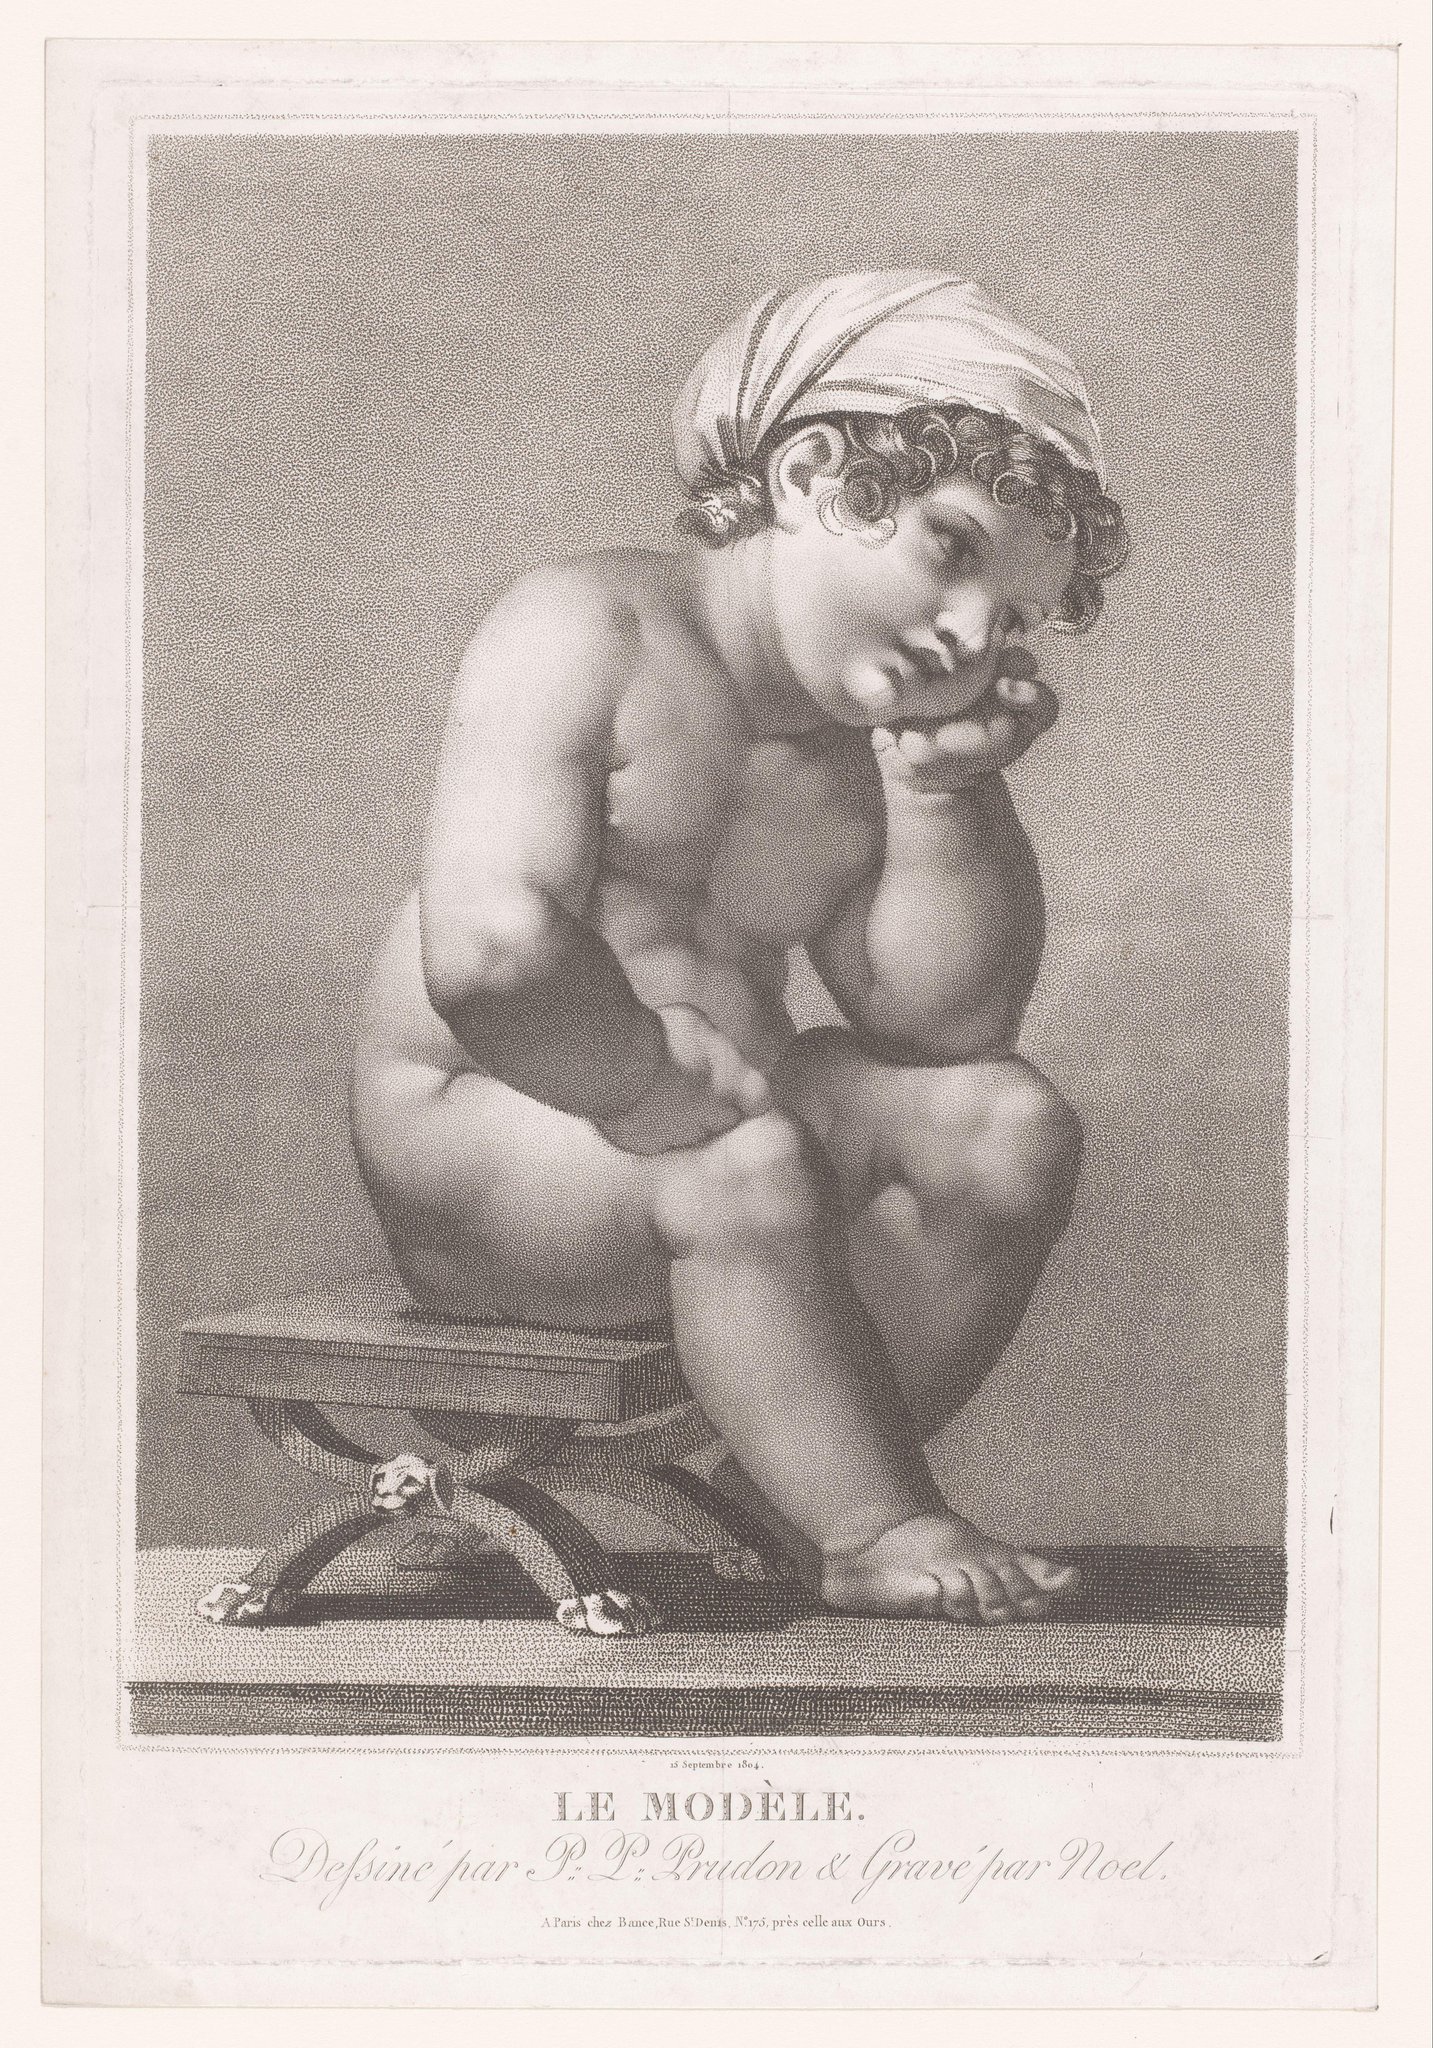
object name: print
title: Le Modèle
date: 1804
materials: paper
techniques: etching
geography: paris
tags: artist's model, sitter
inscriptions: collector's mark: Lugt 2228